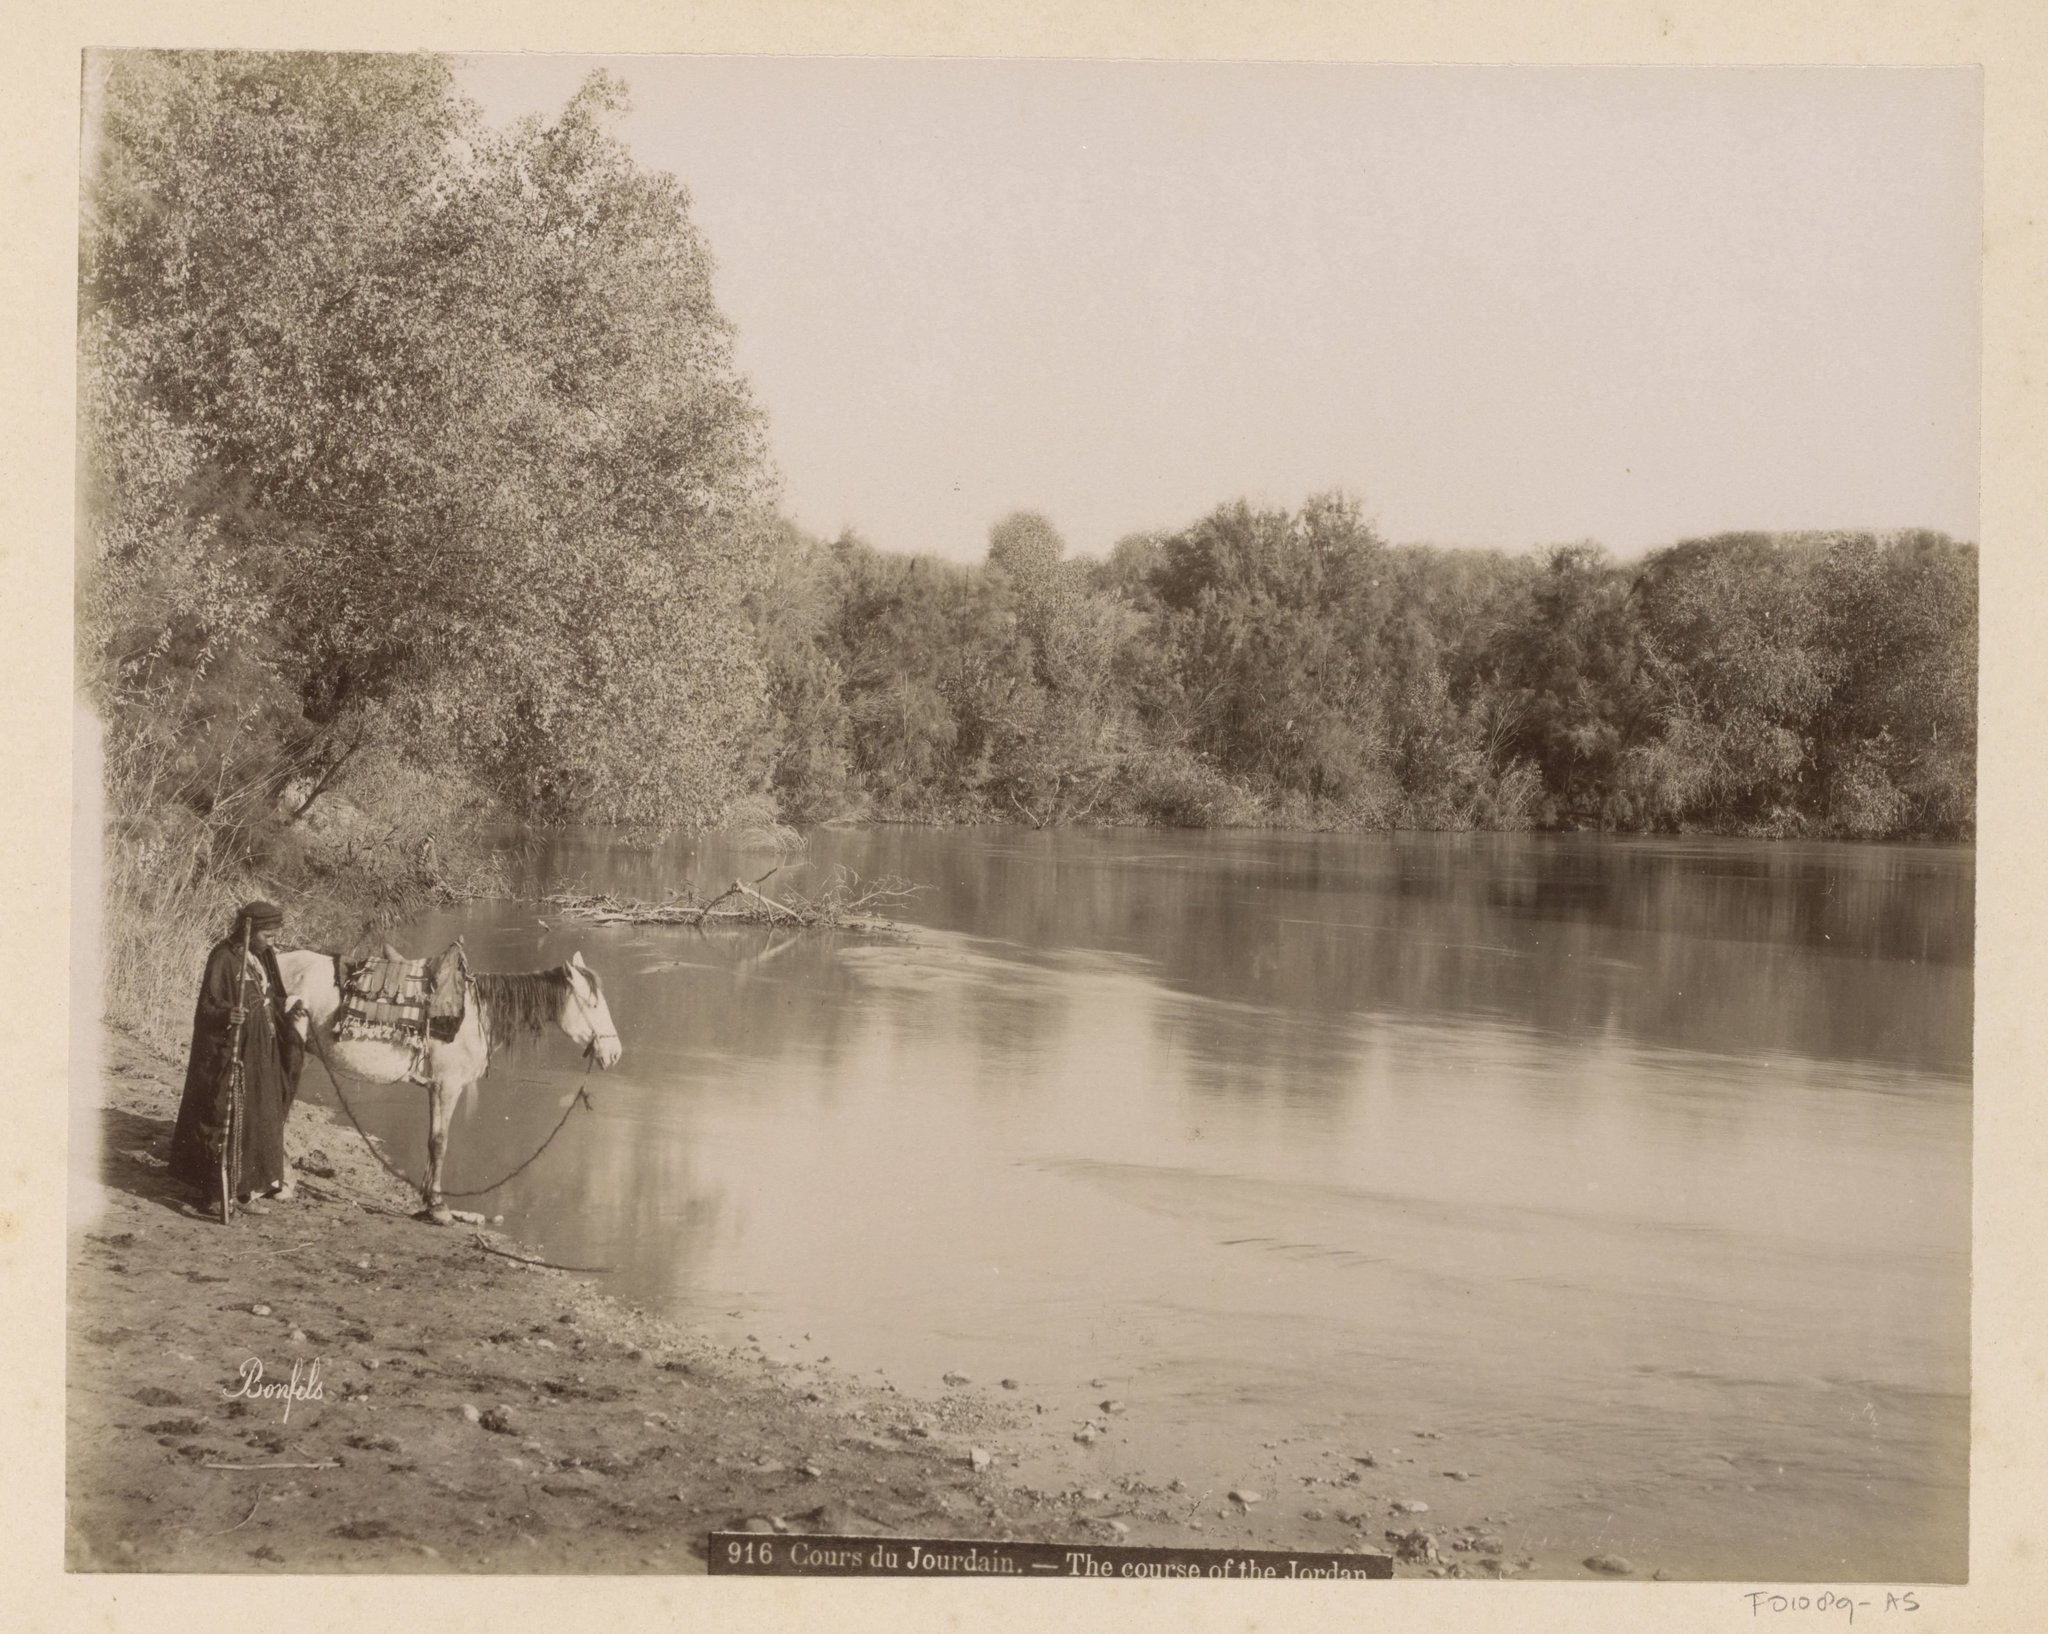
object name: photograph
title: Man met een paard aan de oever van de Jordaan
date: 1867-1895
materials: cardboard, paper, photographic support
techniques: albumen print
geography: jordan river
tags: riding a horse, ass, or mule; rider, horseman, river (+ landscape with figures, staffage)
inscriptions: negative number: ‘916’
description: Onderdeel van Reisalbum met foto's van Jeruzalem en andere bijbelse plaatsen.